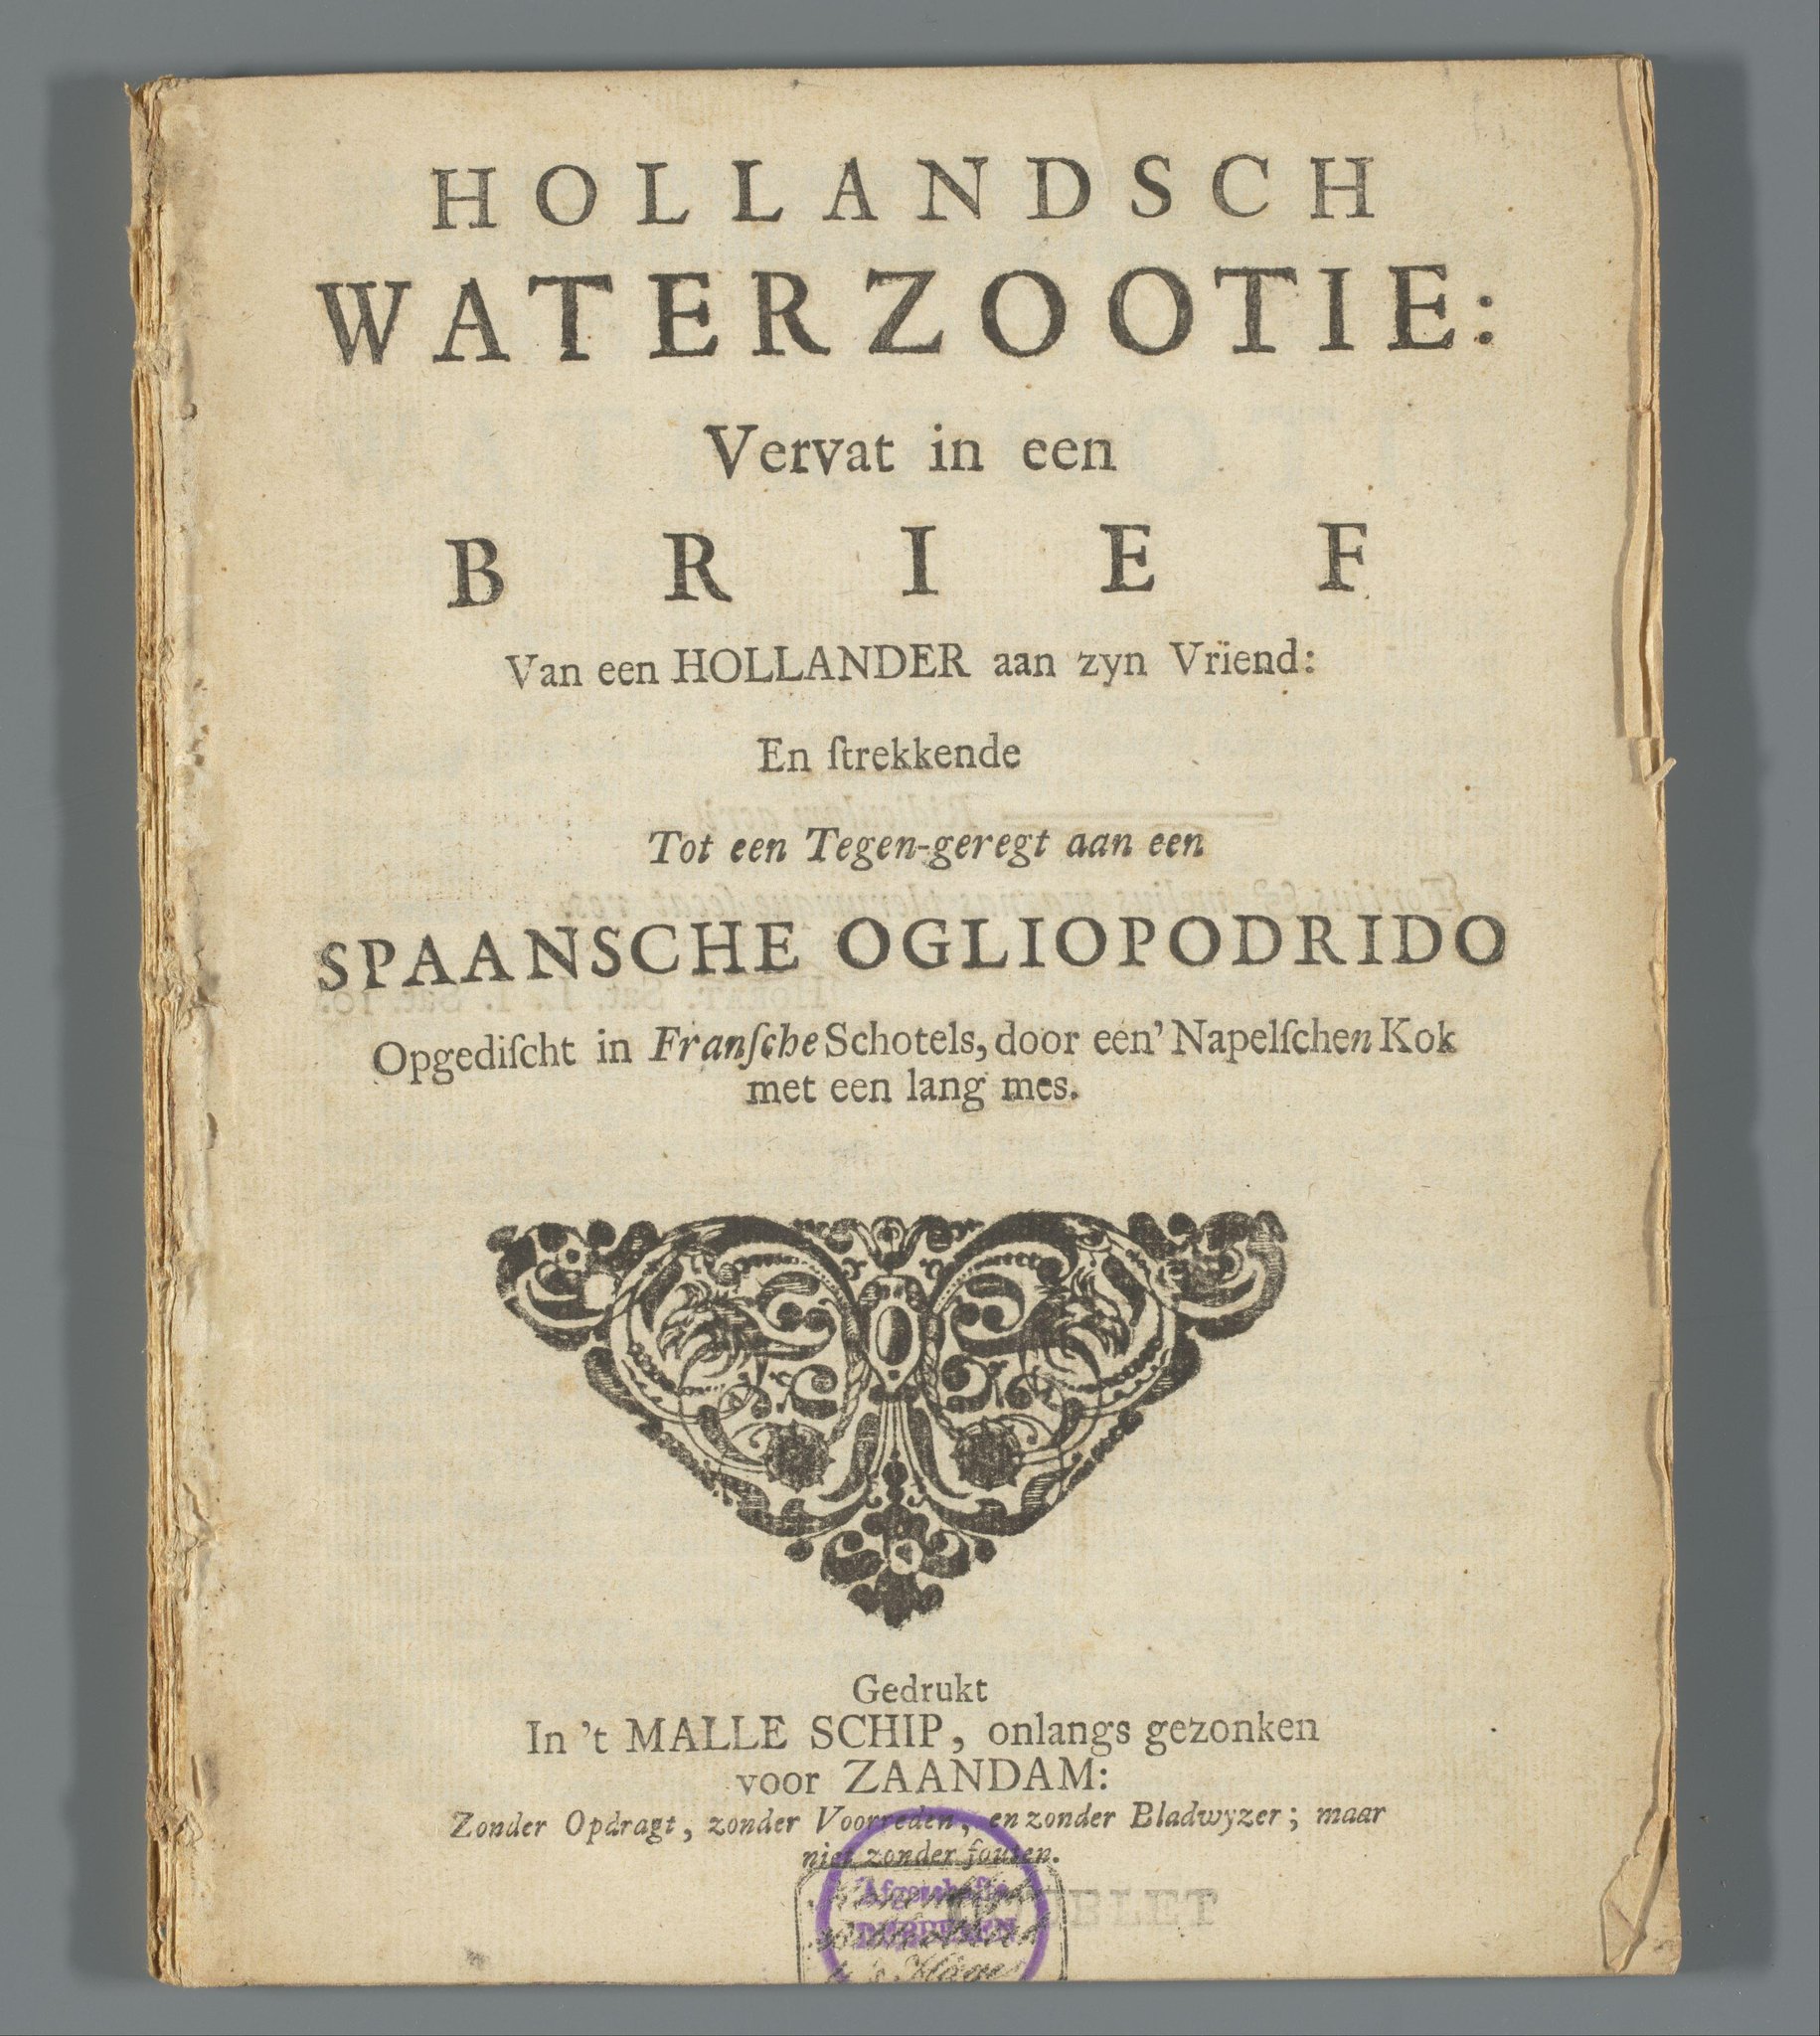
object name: brochure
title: Hollandsch waterzootie: vervat in een brief van een Hollander aan zyn Vriend: en strekkende tot een tegengeregt aan een Spaansche Ogliopodrido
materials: cardboard, paper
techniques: printing, sewing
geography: zaandam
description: 78 genummerde pp, ingenaaid maar omslag voor en op de rug ontbreekt.